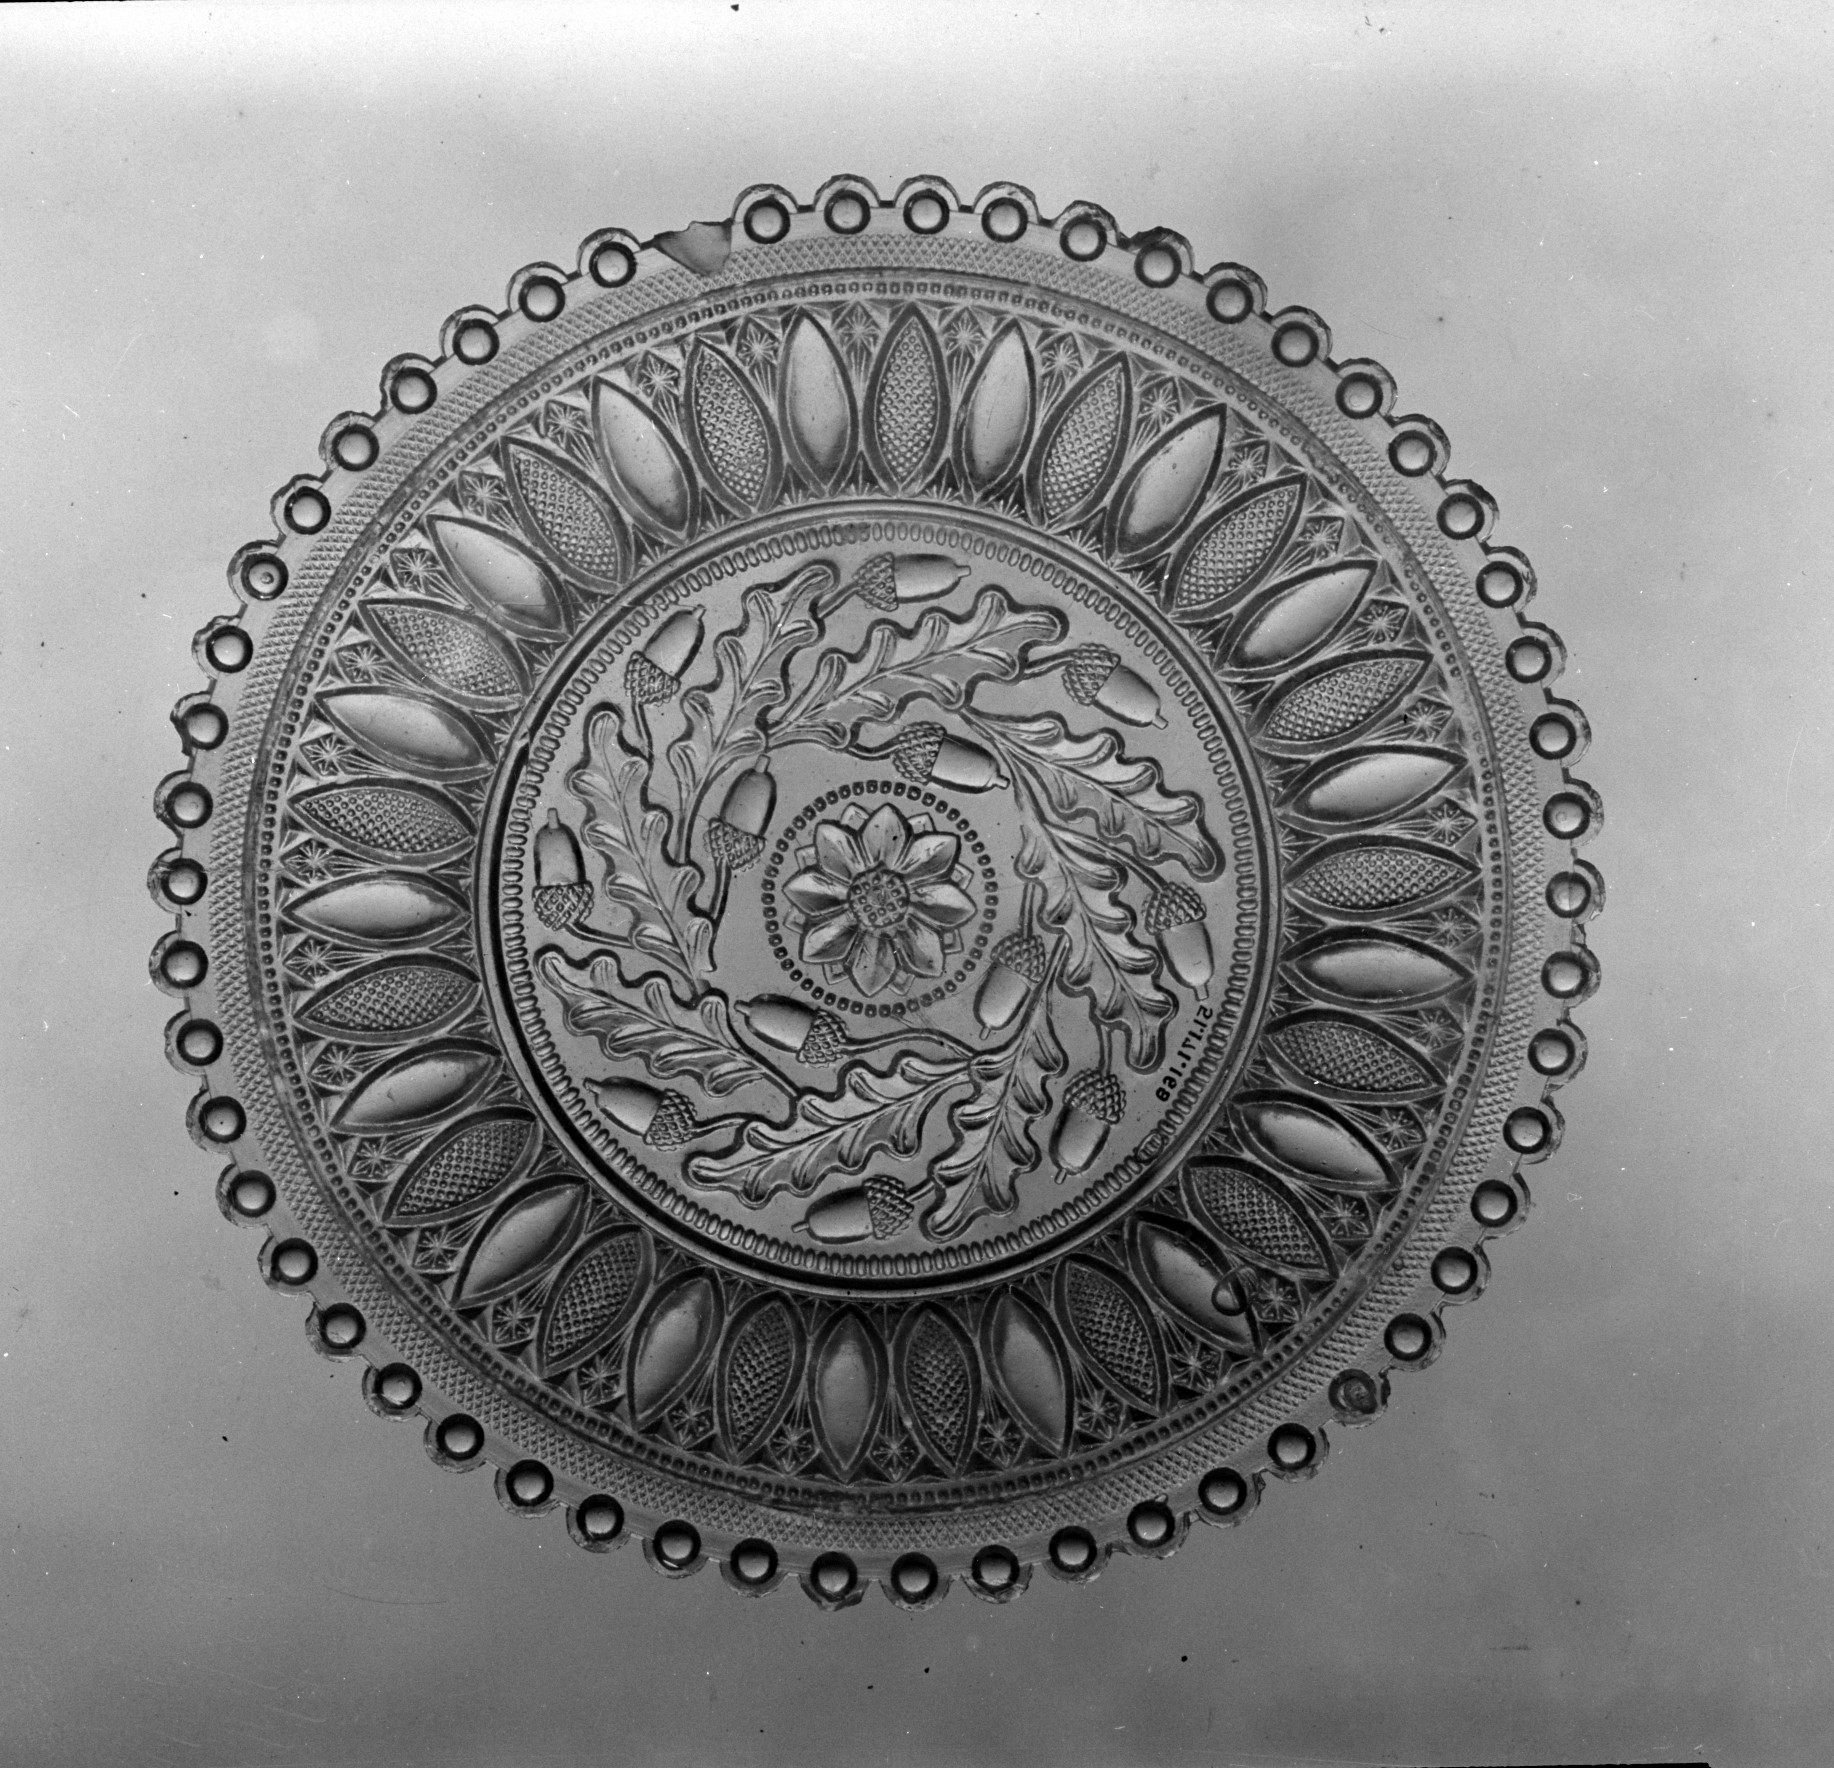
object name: plate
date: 1835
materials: glass